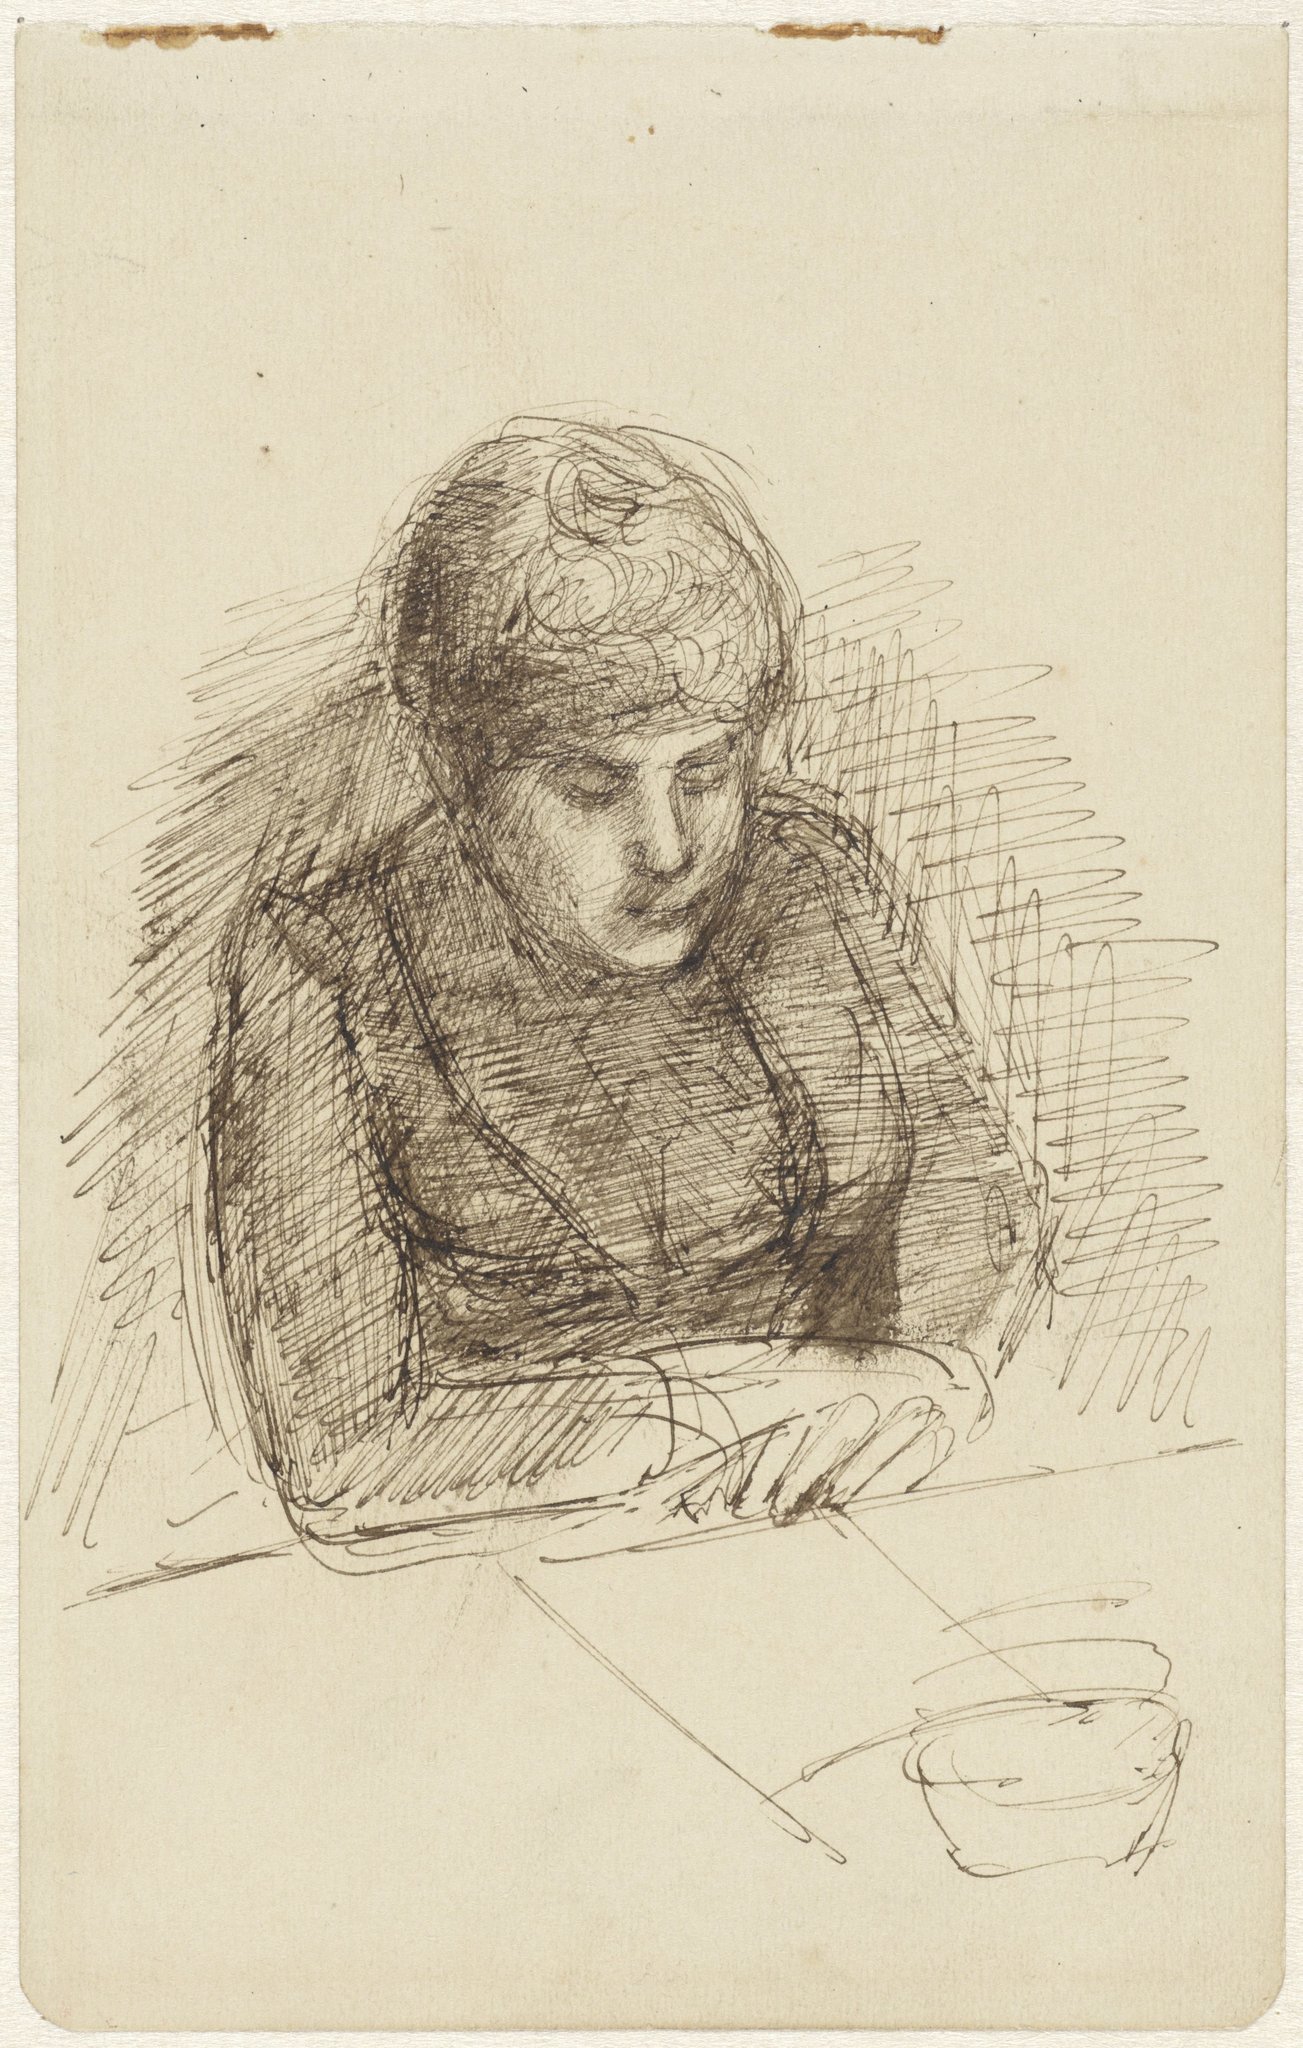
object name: drawing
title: Vrouw aan een tafel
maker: jozef israëls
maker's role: draughtsman, painter, print maker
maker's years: 1824-1911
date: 1834-1911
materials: ink, paper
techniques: pen